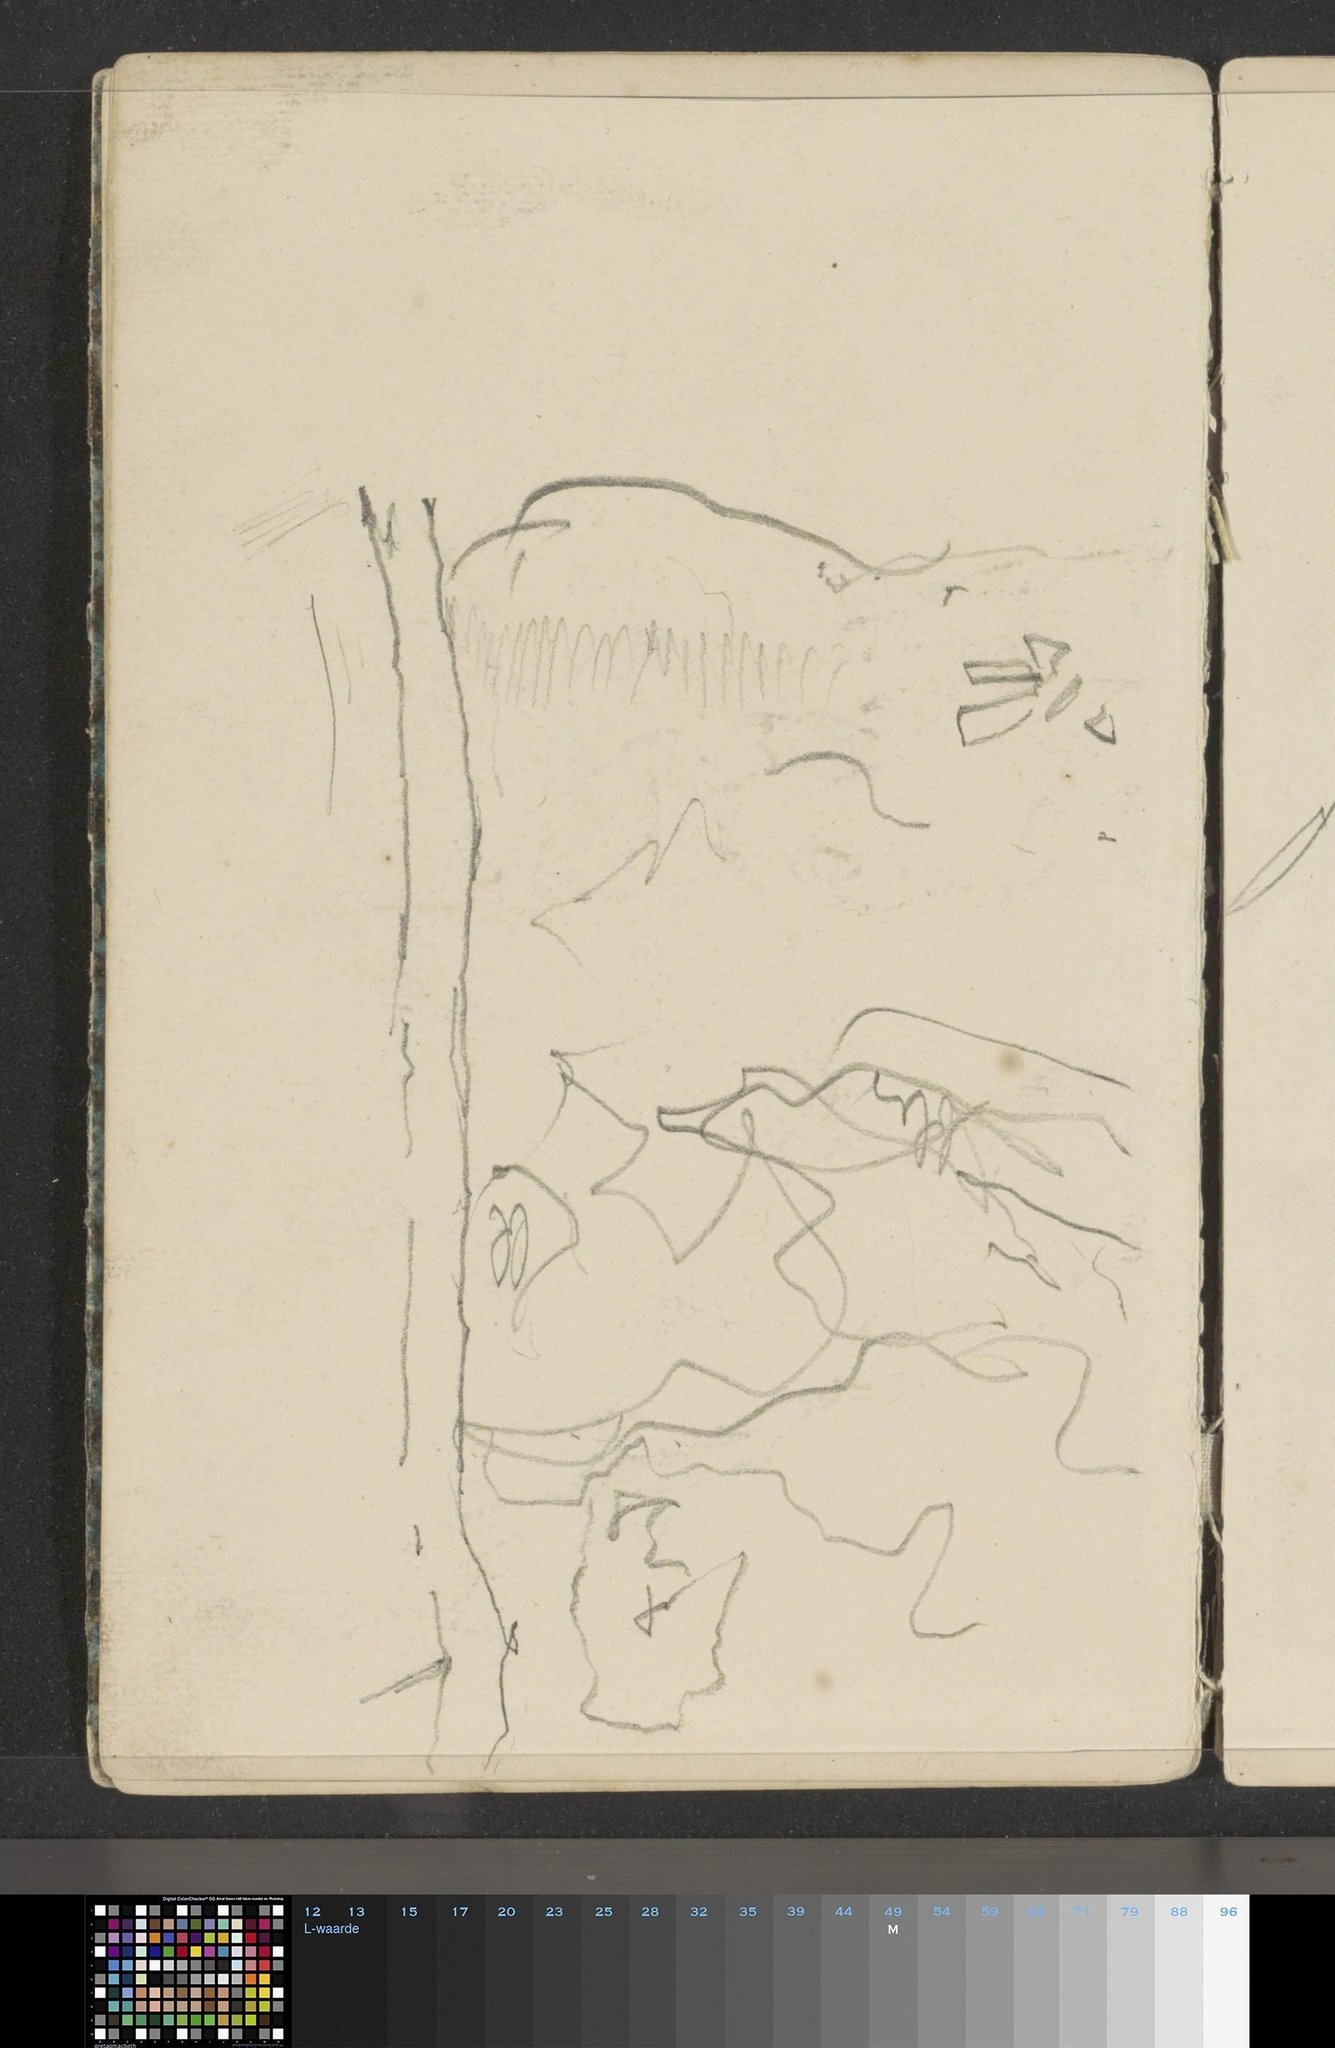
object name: sketchbook leaf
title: Studie, mogelijk van een wolkenlucht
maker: george hendrik breitner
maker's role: draughtsman, painter, print maker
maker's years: 1857-1923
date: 1886-1903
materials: paper, pencil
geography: amsterdam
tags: clouds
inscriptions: kleurnotitie, handgeschreven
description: Pagina 9 uit een schetsboek met 16 bladen.